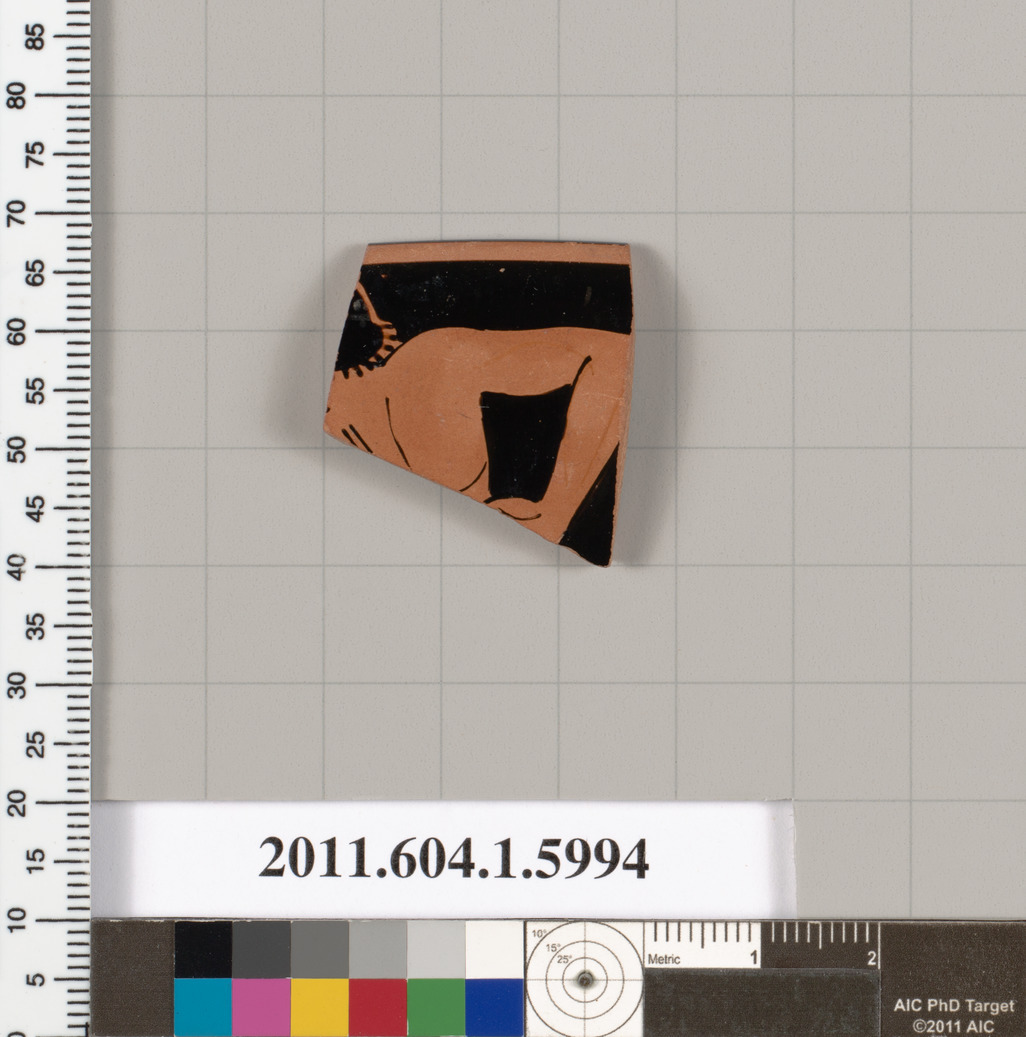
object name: kylix fragment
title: Terracotta rim fragment of a kylix (drinking cup)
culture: greek, attic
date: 510-500 BCE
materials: terracotta